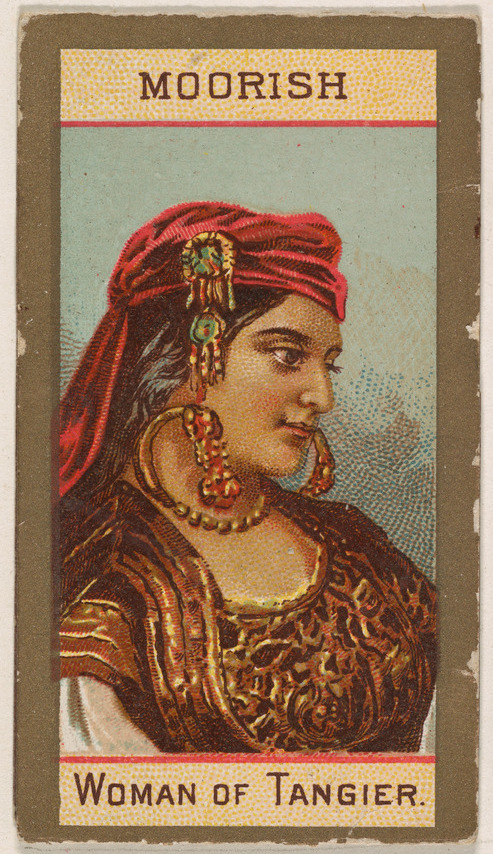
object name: print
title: Moorish, Woman of Tangier, from Types of Nationalities (N240) issued by Kinney Bros.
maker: kinney brothers tobacco company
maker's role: publisher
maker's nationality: american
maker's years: 1869-2011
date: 1890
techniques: color lithograph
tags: women